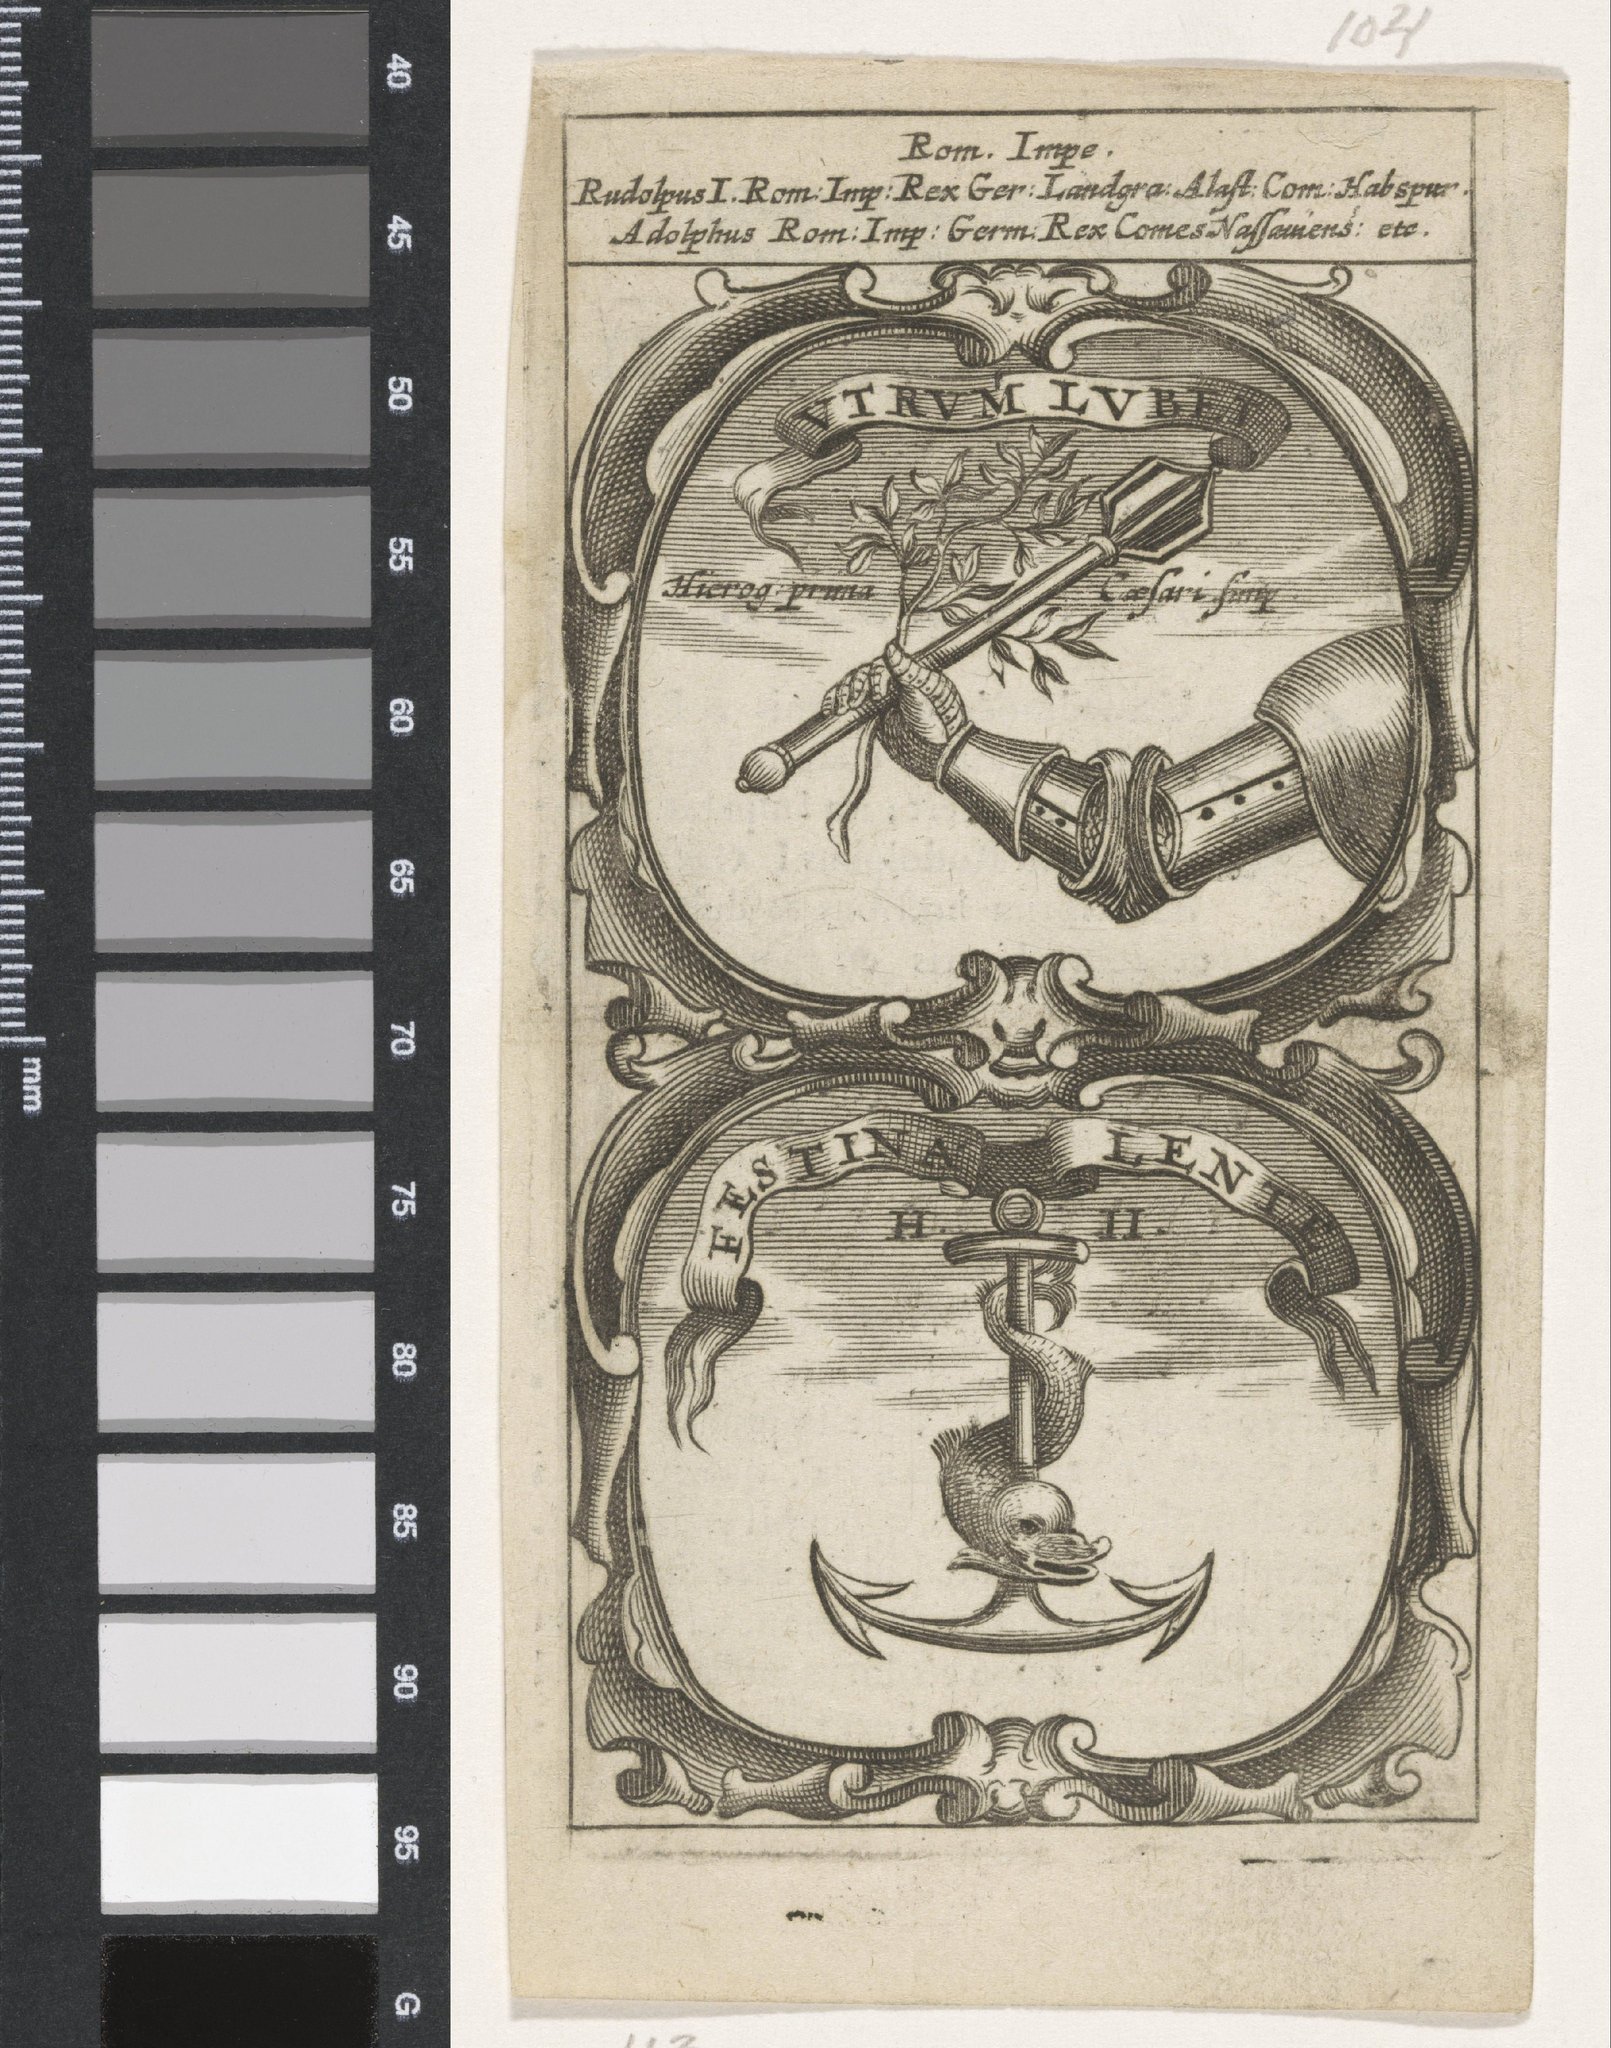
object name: print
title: Utrum Lubet / Festina Lente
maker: Anonymous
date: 1666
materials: paper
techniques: engraving, letterpress printing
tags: swimming mammals: dolphin, weapons, postures and gestures of arms and hands, parts of ship's exterior: anchor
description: Pagina uit Jacob Typotius, Symbola Divina & Humana Pontificum Imperatorum Regum. Arnhem, J.F. Hagen, 1666 of uit de titeluitgave van 1669 of 1679. Het werk van Typotius werd voor het eerst uitgegeven in 1601 met prenten van Aegidius Sadeler.